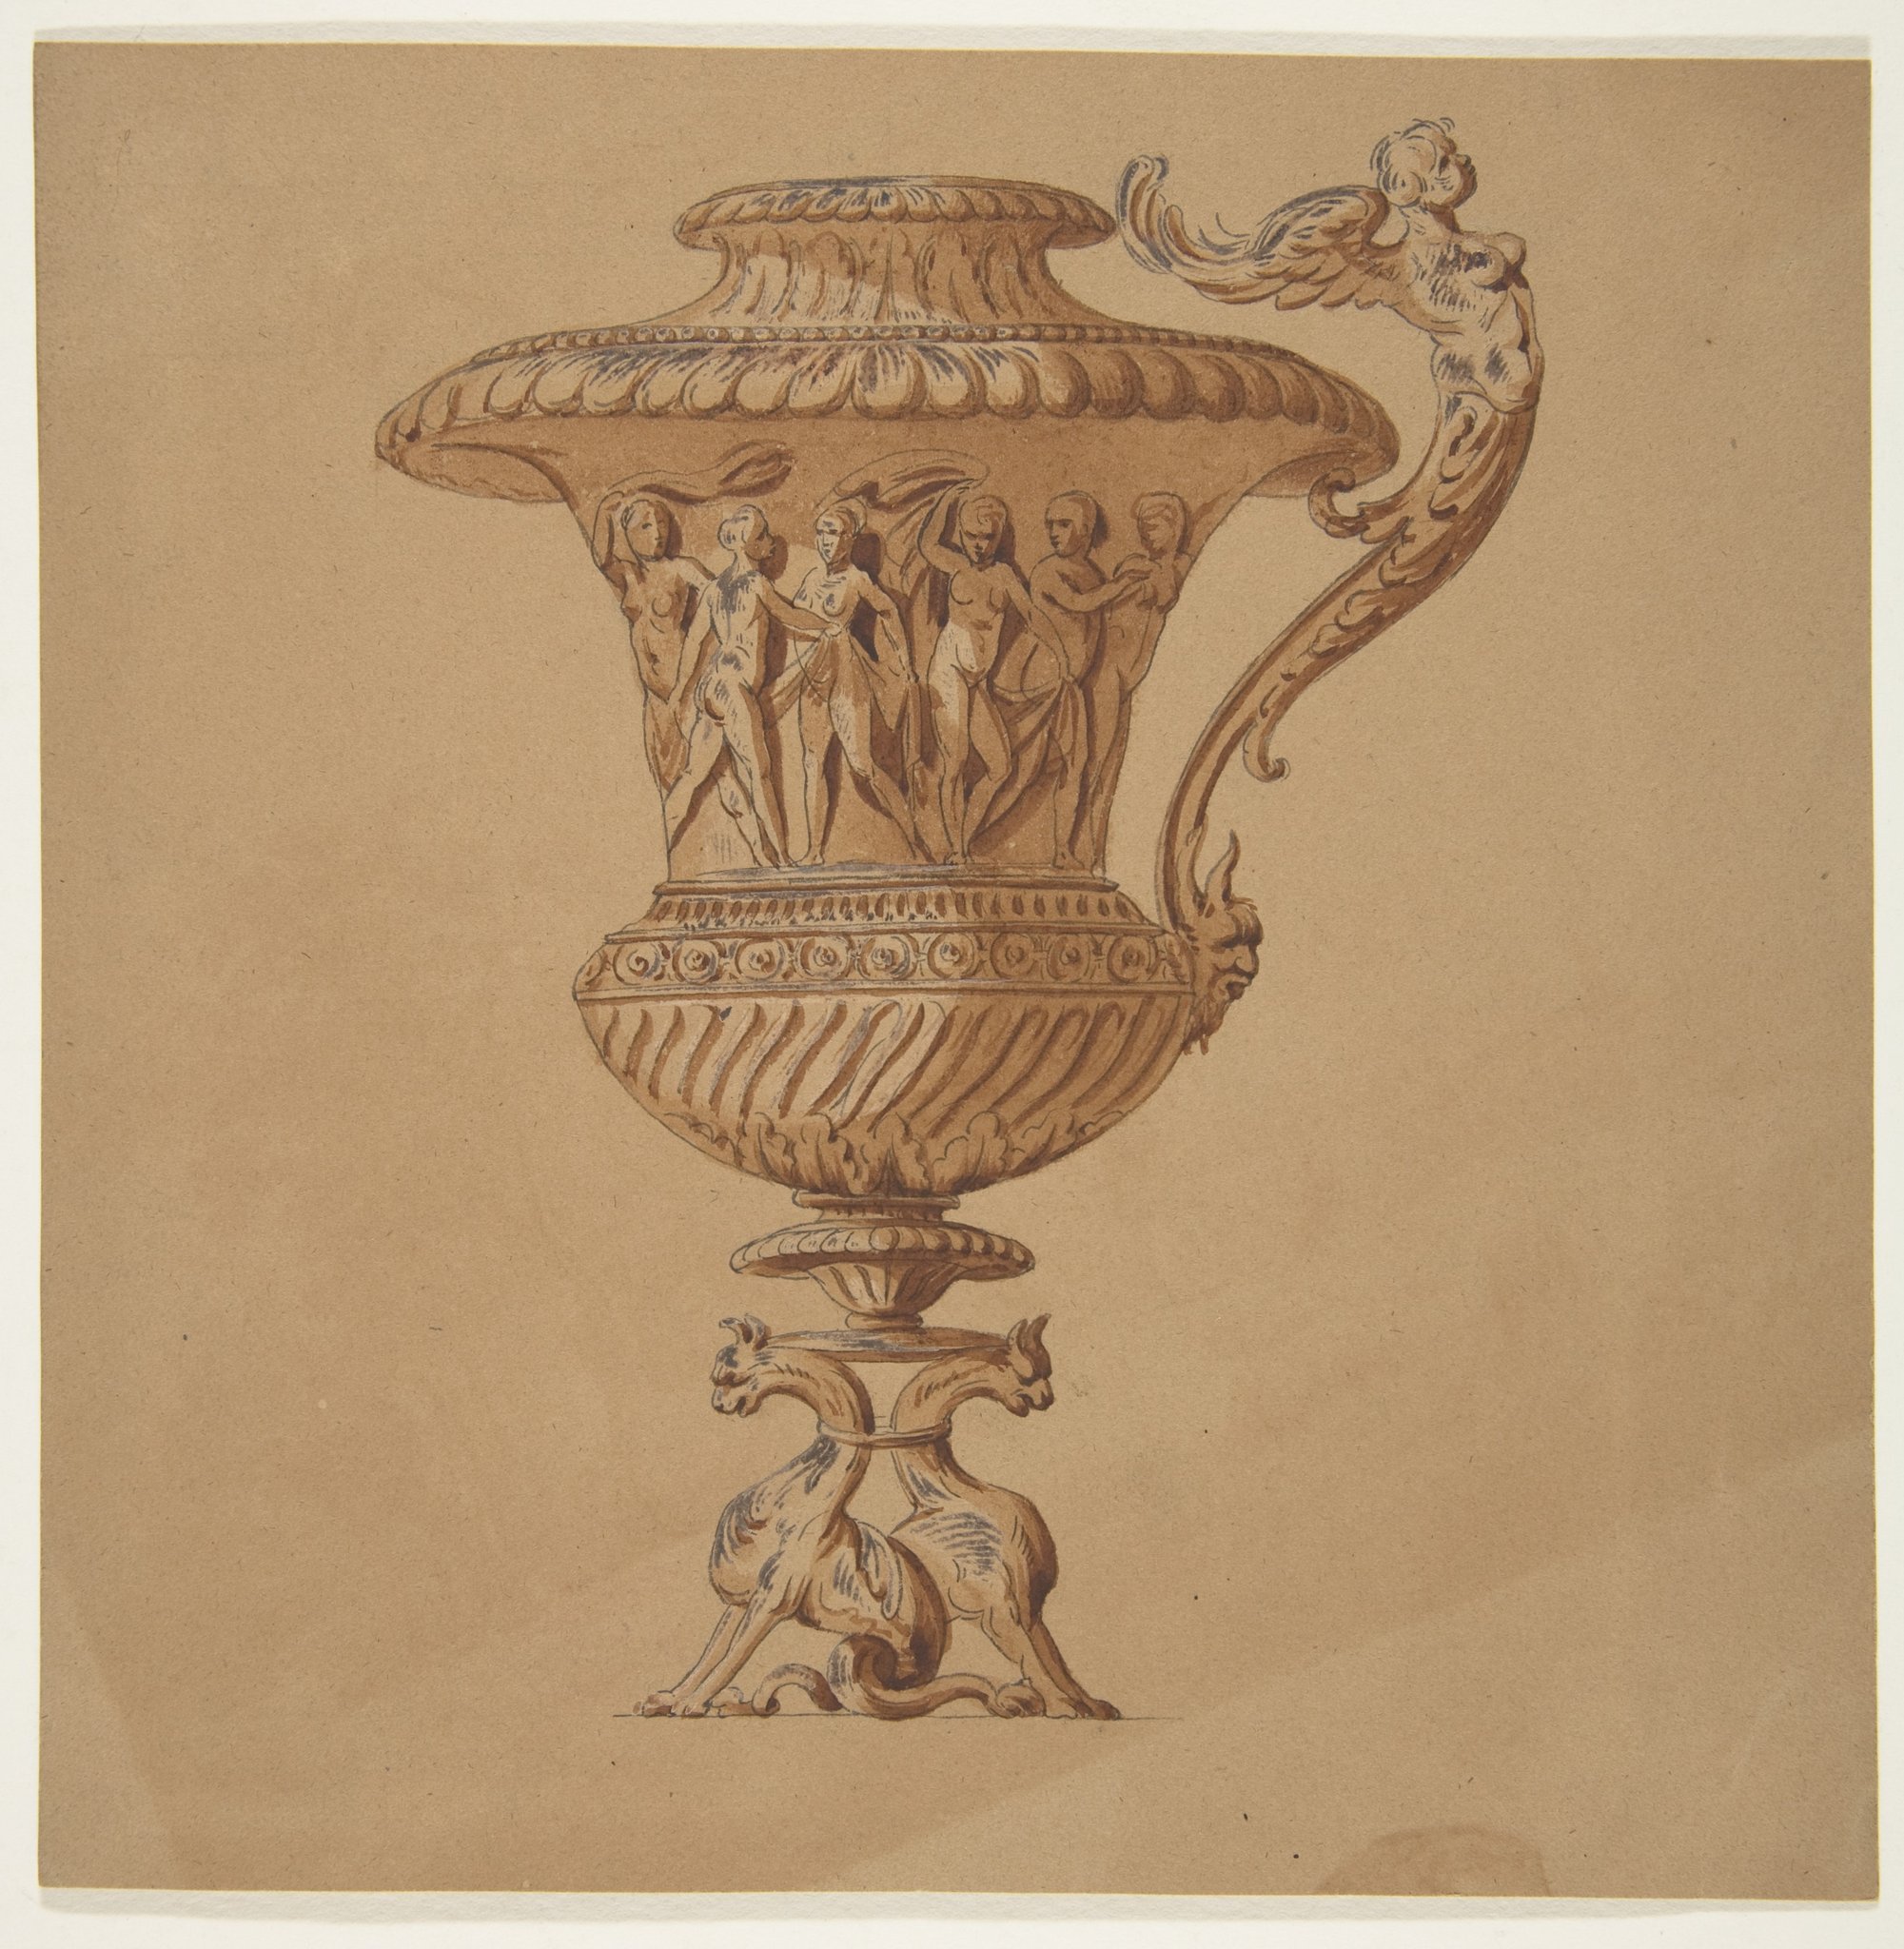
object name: drawing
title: Design for a vessel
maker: anonymous, french, 19th century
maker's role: artist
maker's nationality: french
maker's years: 1800-1900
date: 1801-1900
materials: graphite, paper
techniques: wash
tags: vessels